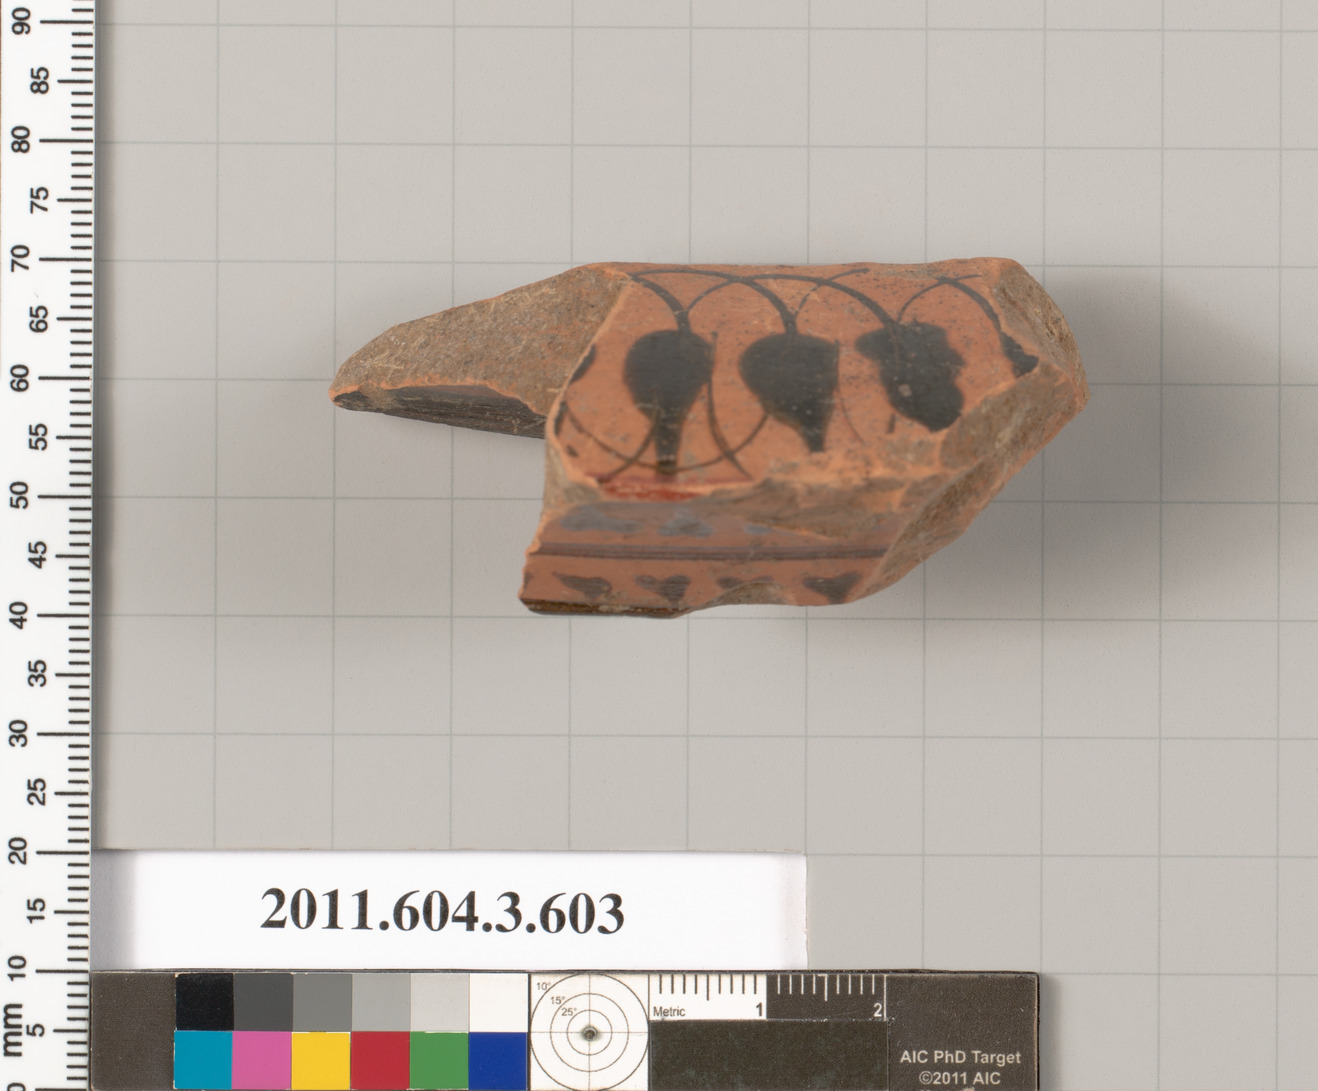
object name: column krater fragment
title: Terracotta fragment of a column-krater (bowl for mixing wine and water)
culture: greek, attic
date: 525-501 BCE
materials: terracotta